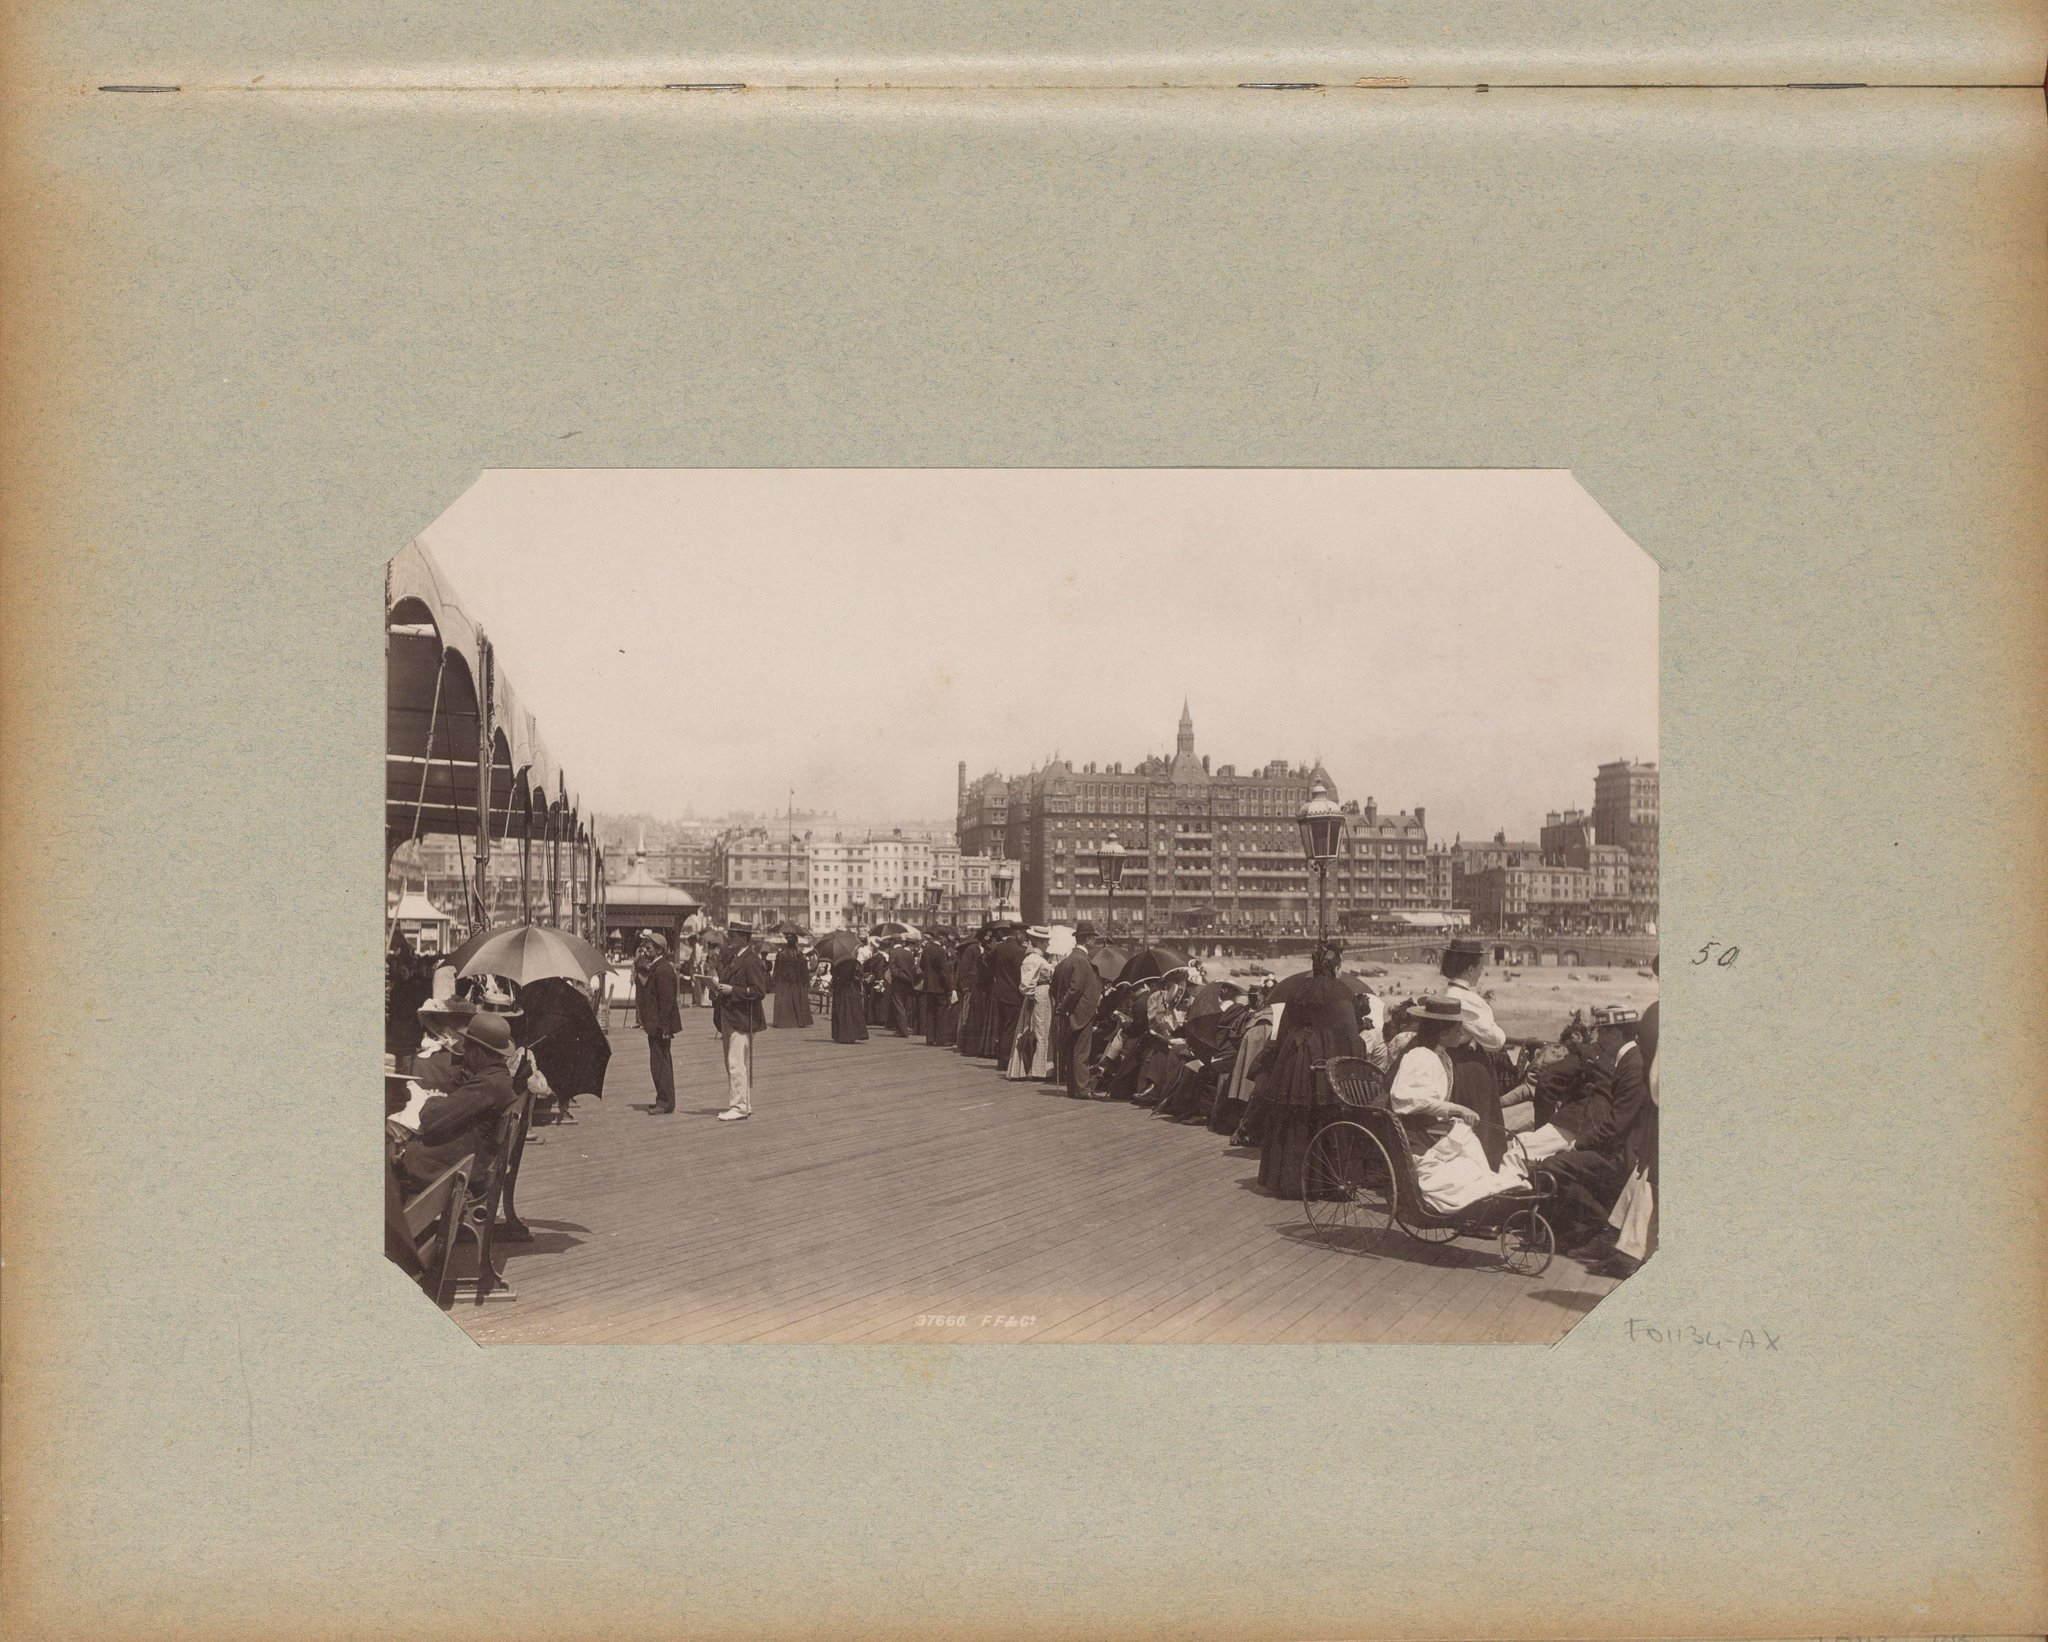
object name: photograph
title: Mensen op de pier van Brighton met op de achtergrond Hotel Metropole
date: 1880-1910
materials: paper, photographic support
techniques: albumen print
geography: brighton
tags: pier, quay, wharf, hotel, hostelry, inn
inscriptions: number: ‘37660’, check stamp: ‘Spooner & Co., W.M.’, number: ‘7612’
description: Onderdeel van Reisalbum met bezienswaardigheden in Engeland, Zwitserland, Frankrijk en Duitsland.